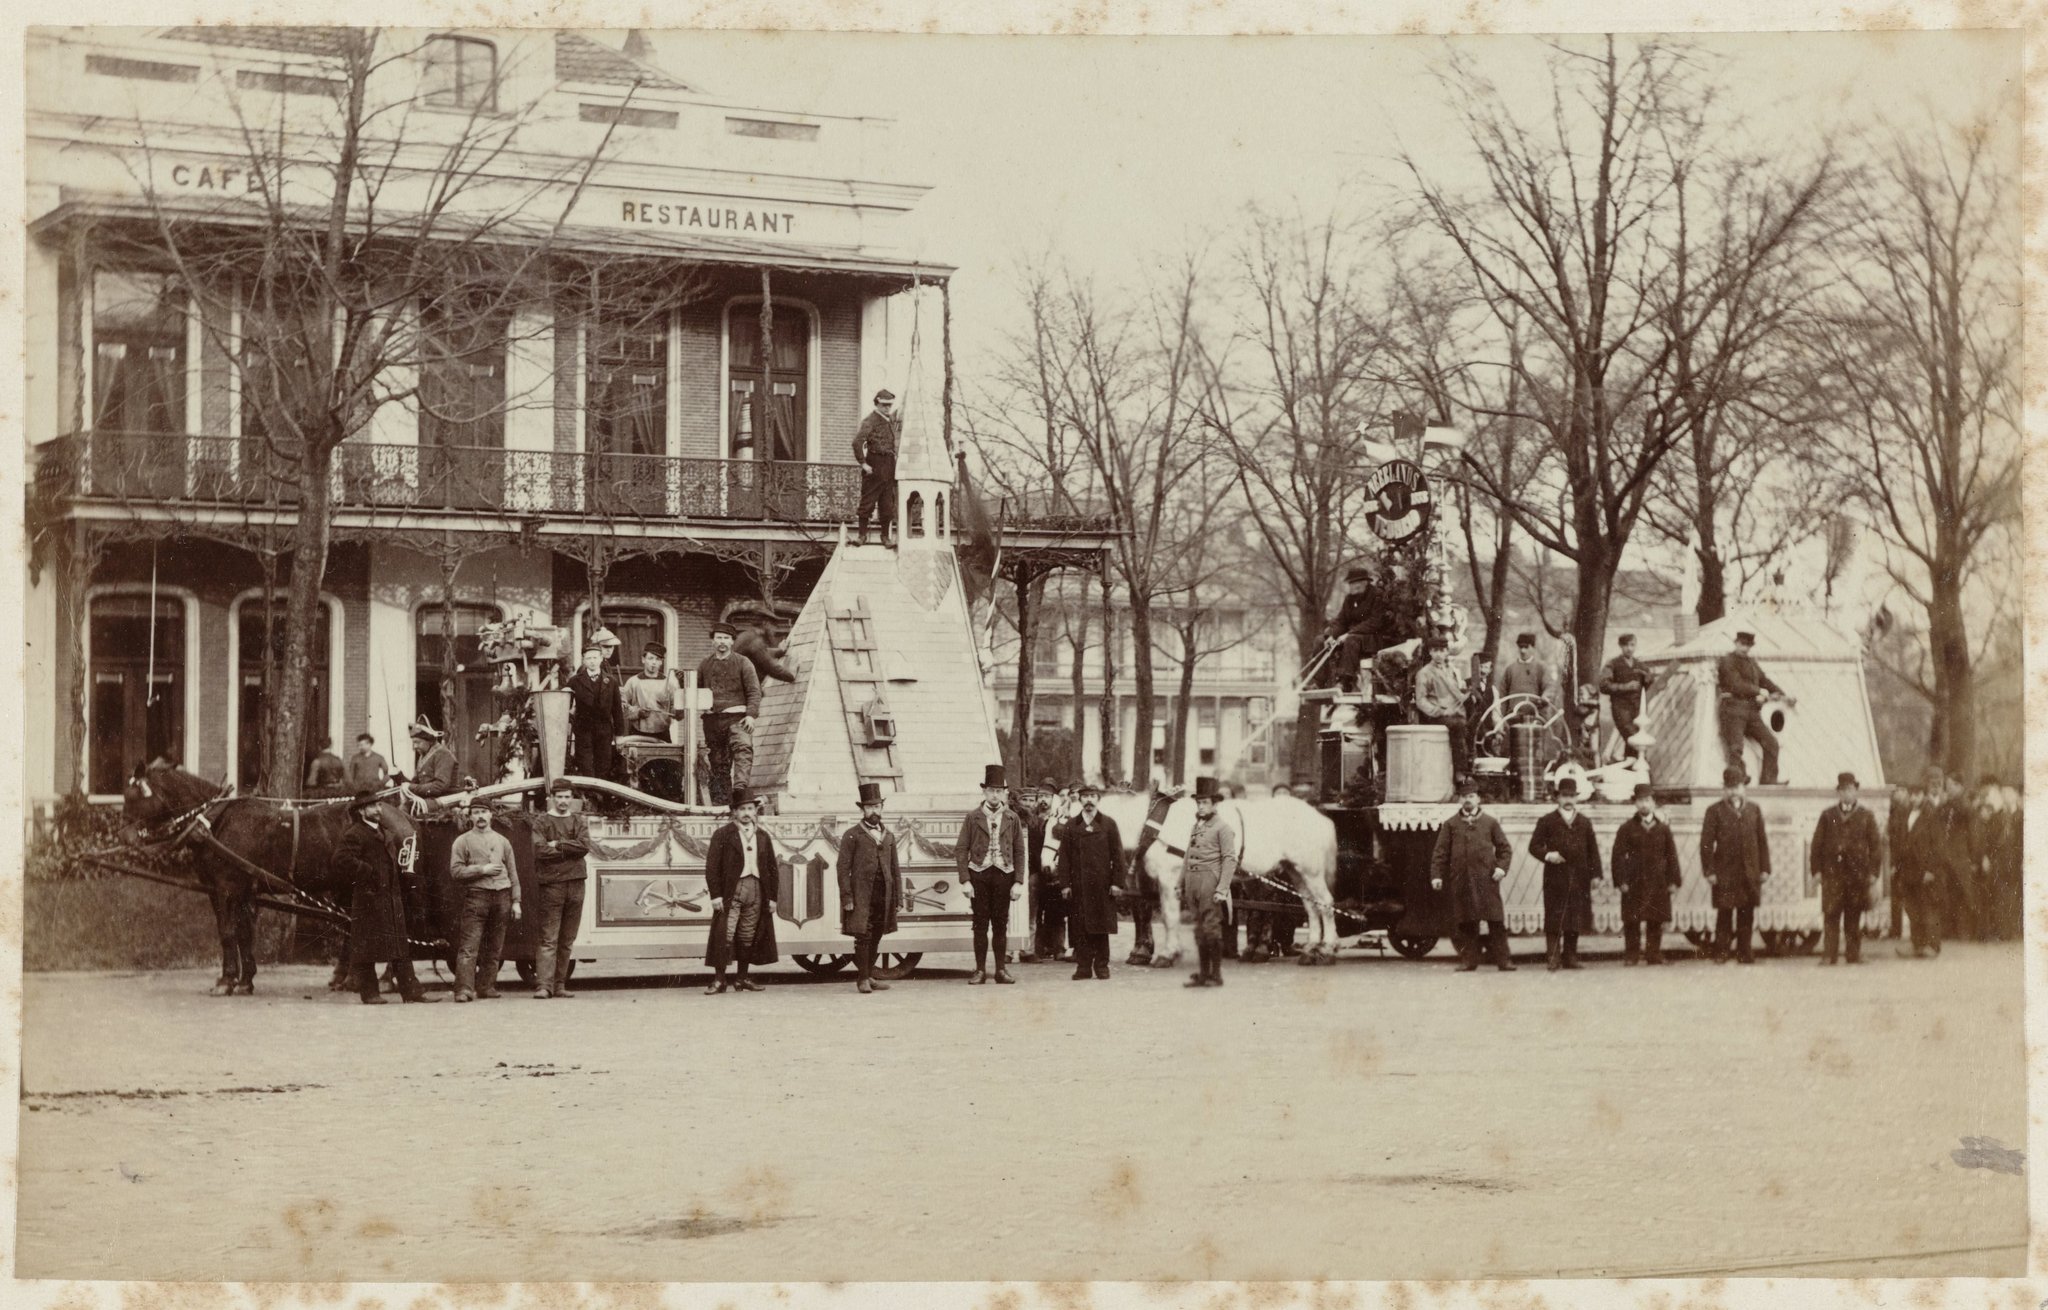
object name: photograph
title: Praalwagens voor de onafhankelijkheidsfeesten in Dordrecht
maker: Anonymous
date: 1888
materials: cardboard, paper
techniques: albumen print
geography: dordrecht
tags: public festivities, dordrecht